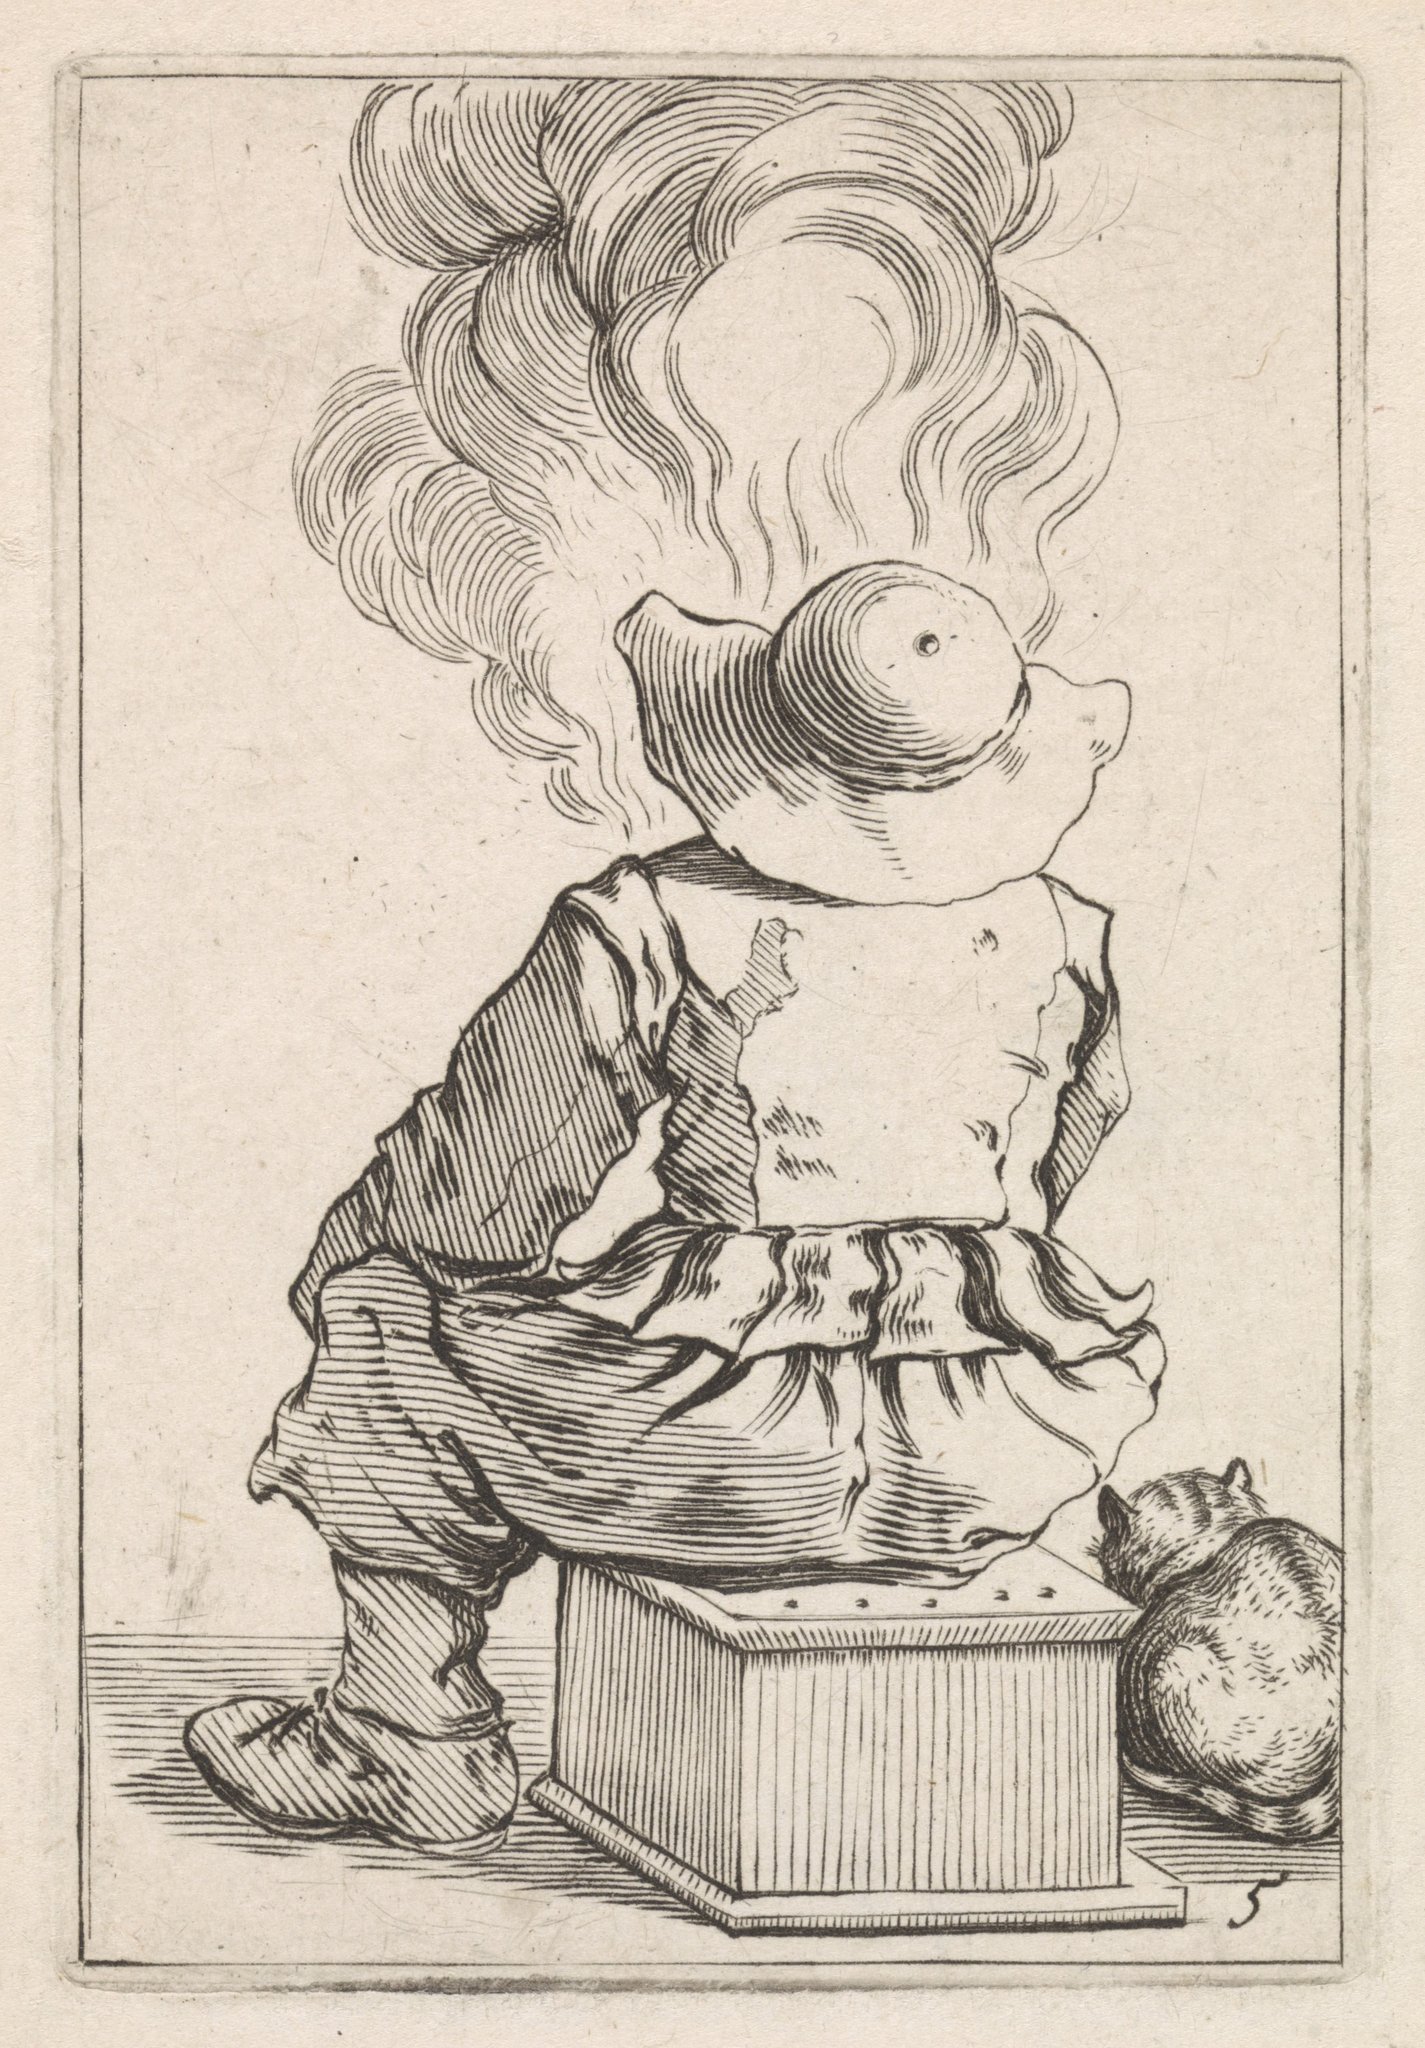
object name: print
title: Zittende rokende man en poes, gezien van achteren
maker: cornelis saftleven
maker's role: draughtsman, painter, print maker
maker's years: 1607-1681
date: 1645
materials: paper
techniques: etching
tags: cat, pipe ~ tobacco, farmers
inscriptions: collector's mark: Lugt 240